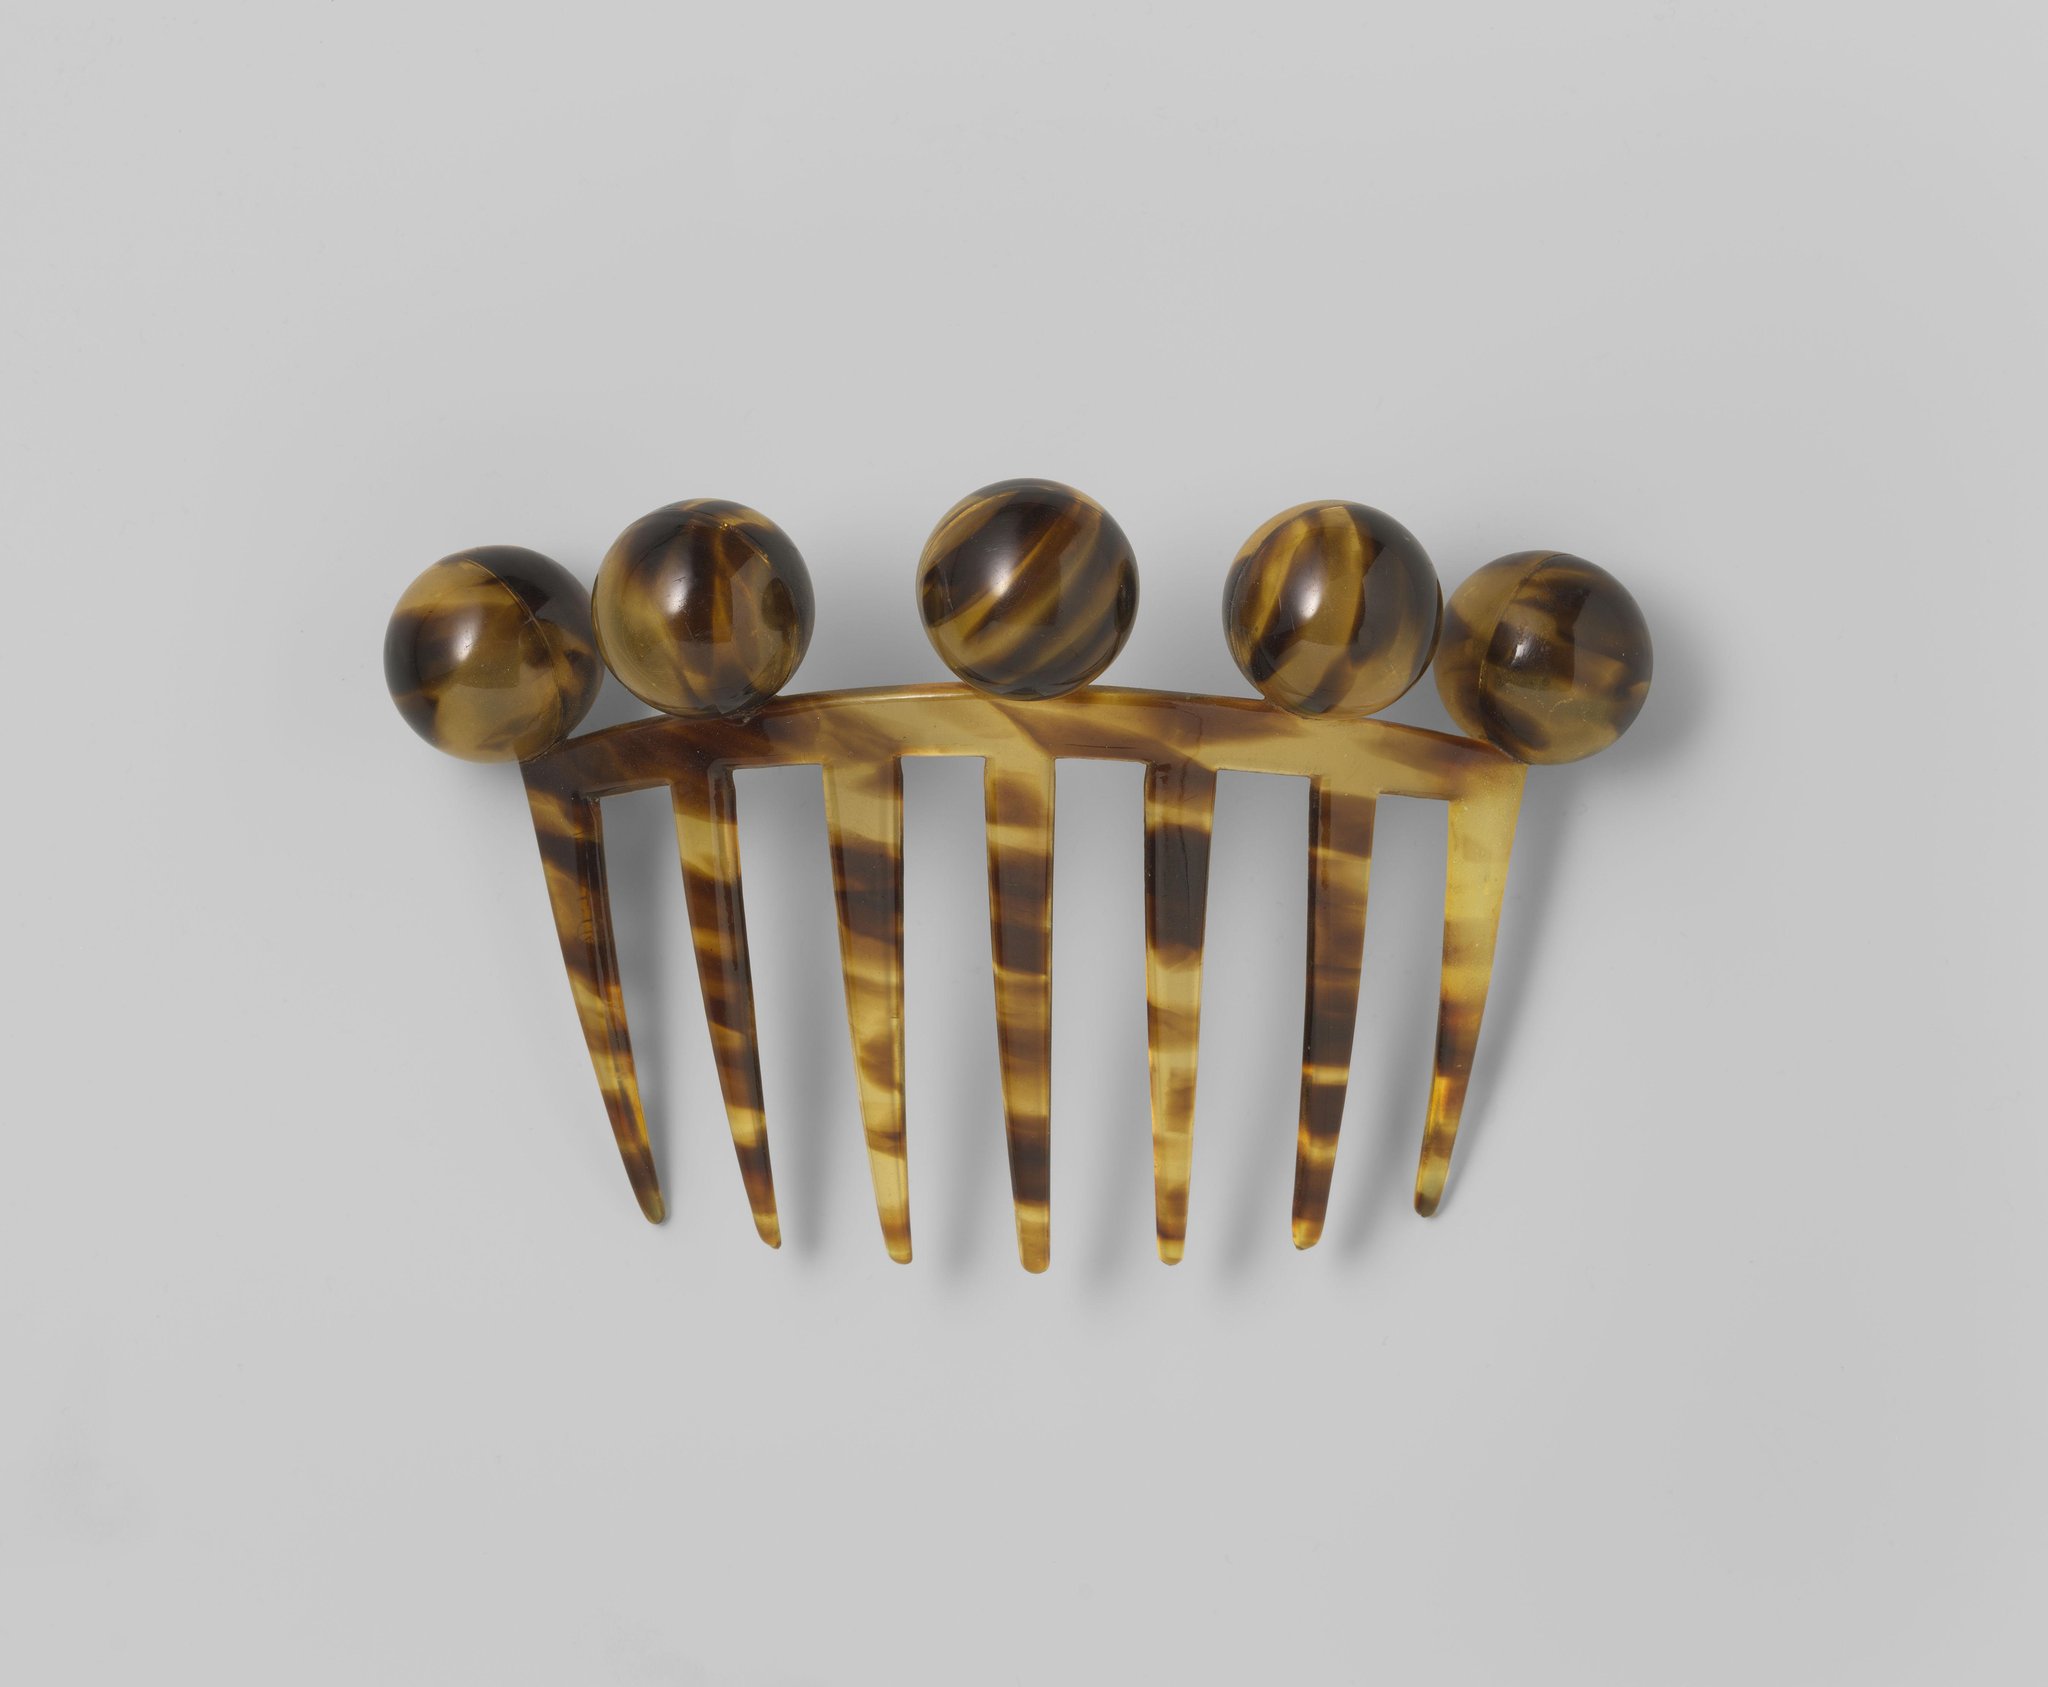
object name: haarkam haarsieraad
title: Haarkam van imitatieschildpad (celluloid)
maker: Anonymous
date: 1880-1885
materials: celluloid, glue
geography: europe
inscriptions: inscription: ‘DEPOSE’, inscription: ‘Auguste Bonan’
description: Boven de kam met zeven tanden zijn vijf ballen vastgelijmd op pinnen. Aan de uiteinden een strikband. De ene strikband is grijs, de andere zwart. De bollen zijn samengesteld uit twee delen.